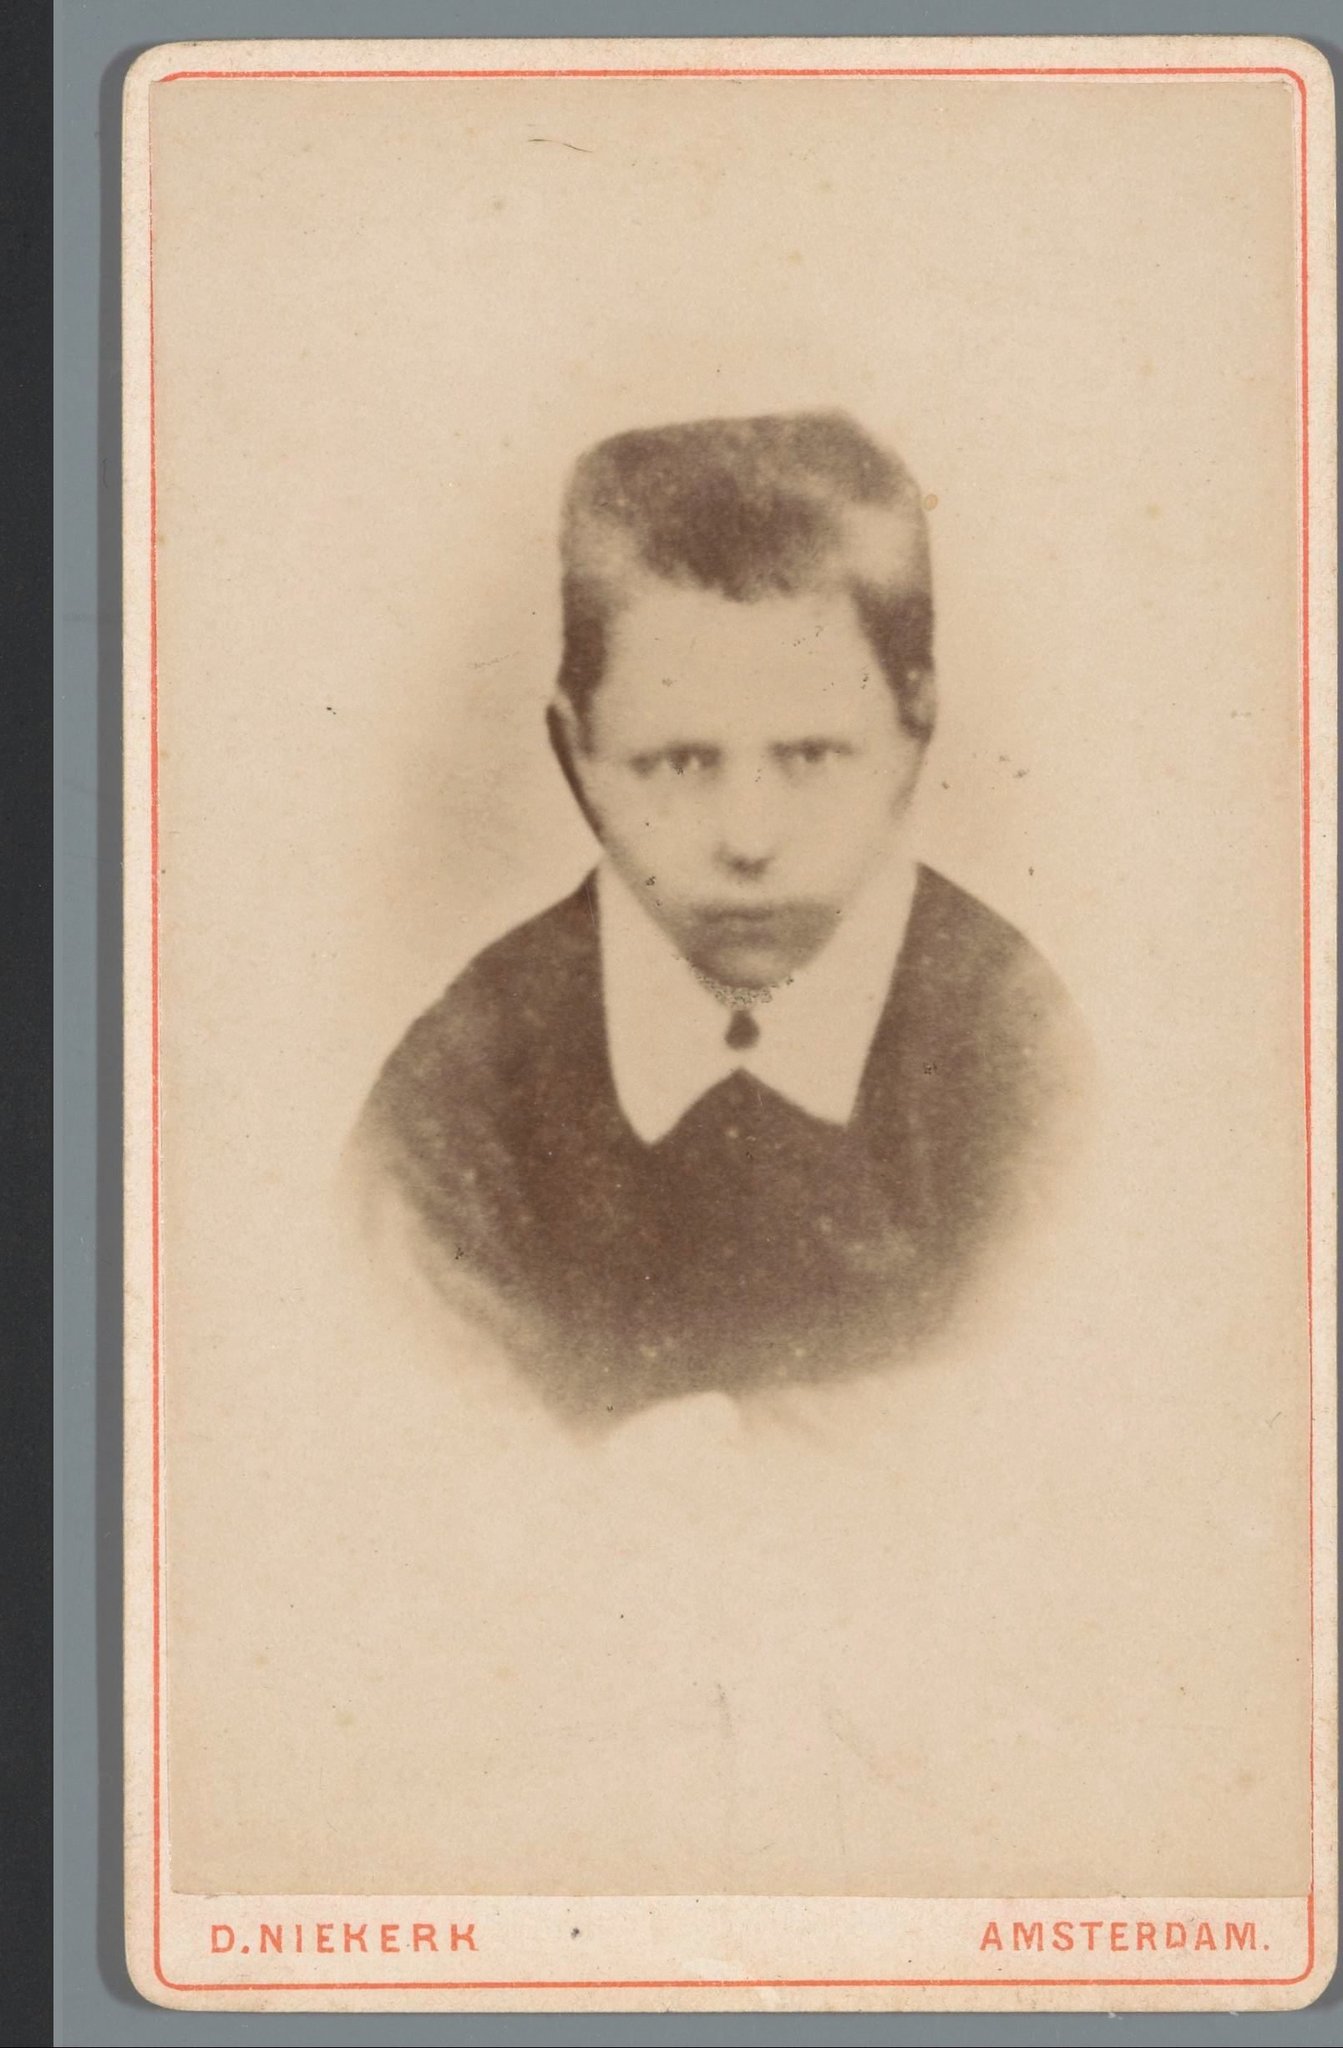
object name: carte de visite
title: Portret van een onbekende jongen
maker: dirk niekerk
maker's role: fotograaf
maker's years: 1824-1881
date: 1879-1881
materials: cardboard, paper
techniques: albumen print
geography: amsterdam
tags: boy (child between toddler and youth), historical persons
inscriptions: inscription: ‘(...)/ Amsterdam 1977/ D. NIEKERK/ Photograaf van Wijlen/ Z.K.H. Prins Hendrik der Nederlanden/ Baangracht tusschen/ Leidsche Plein en/ Kruisstraat/ 248./ AMSTERDAM.’